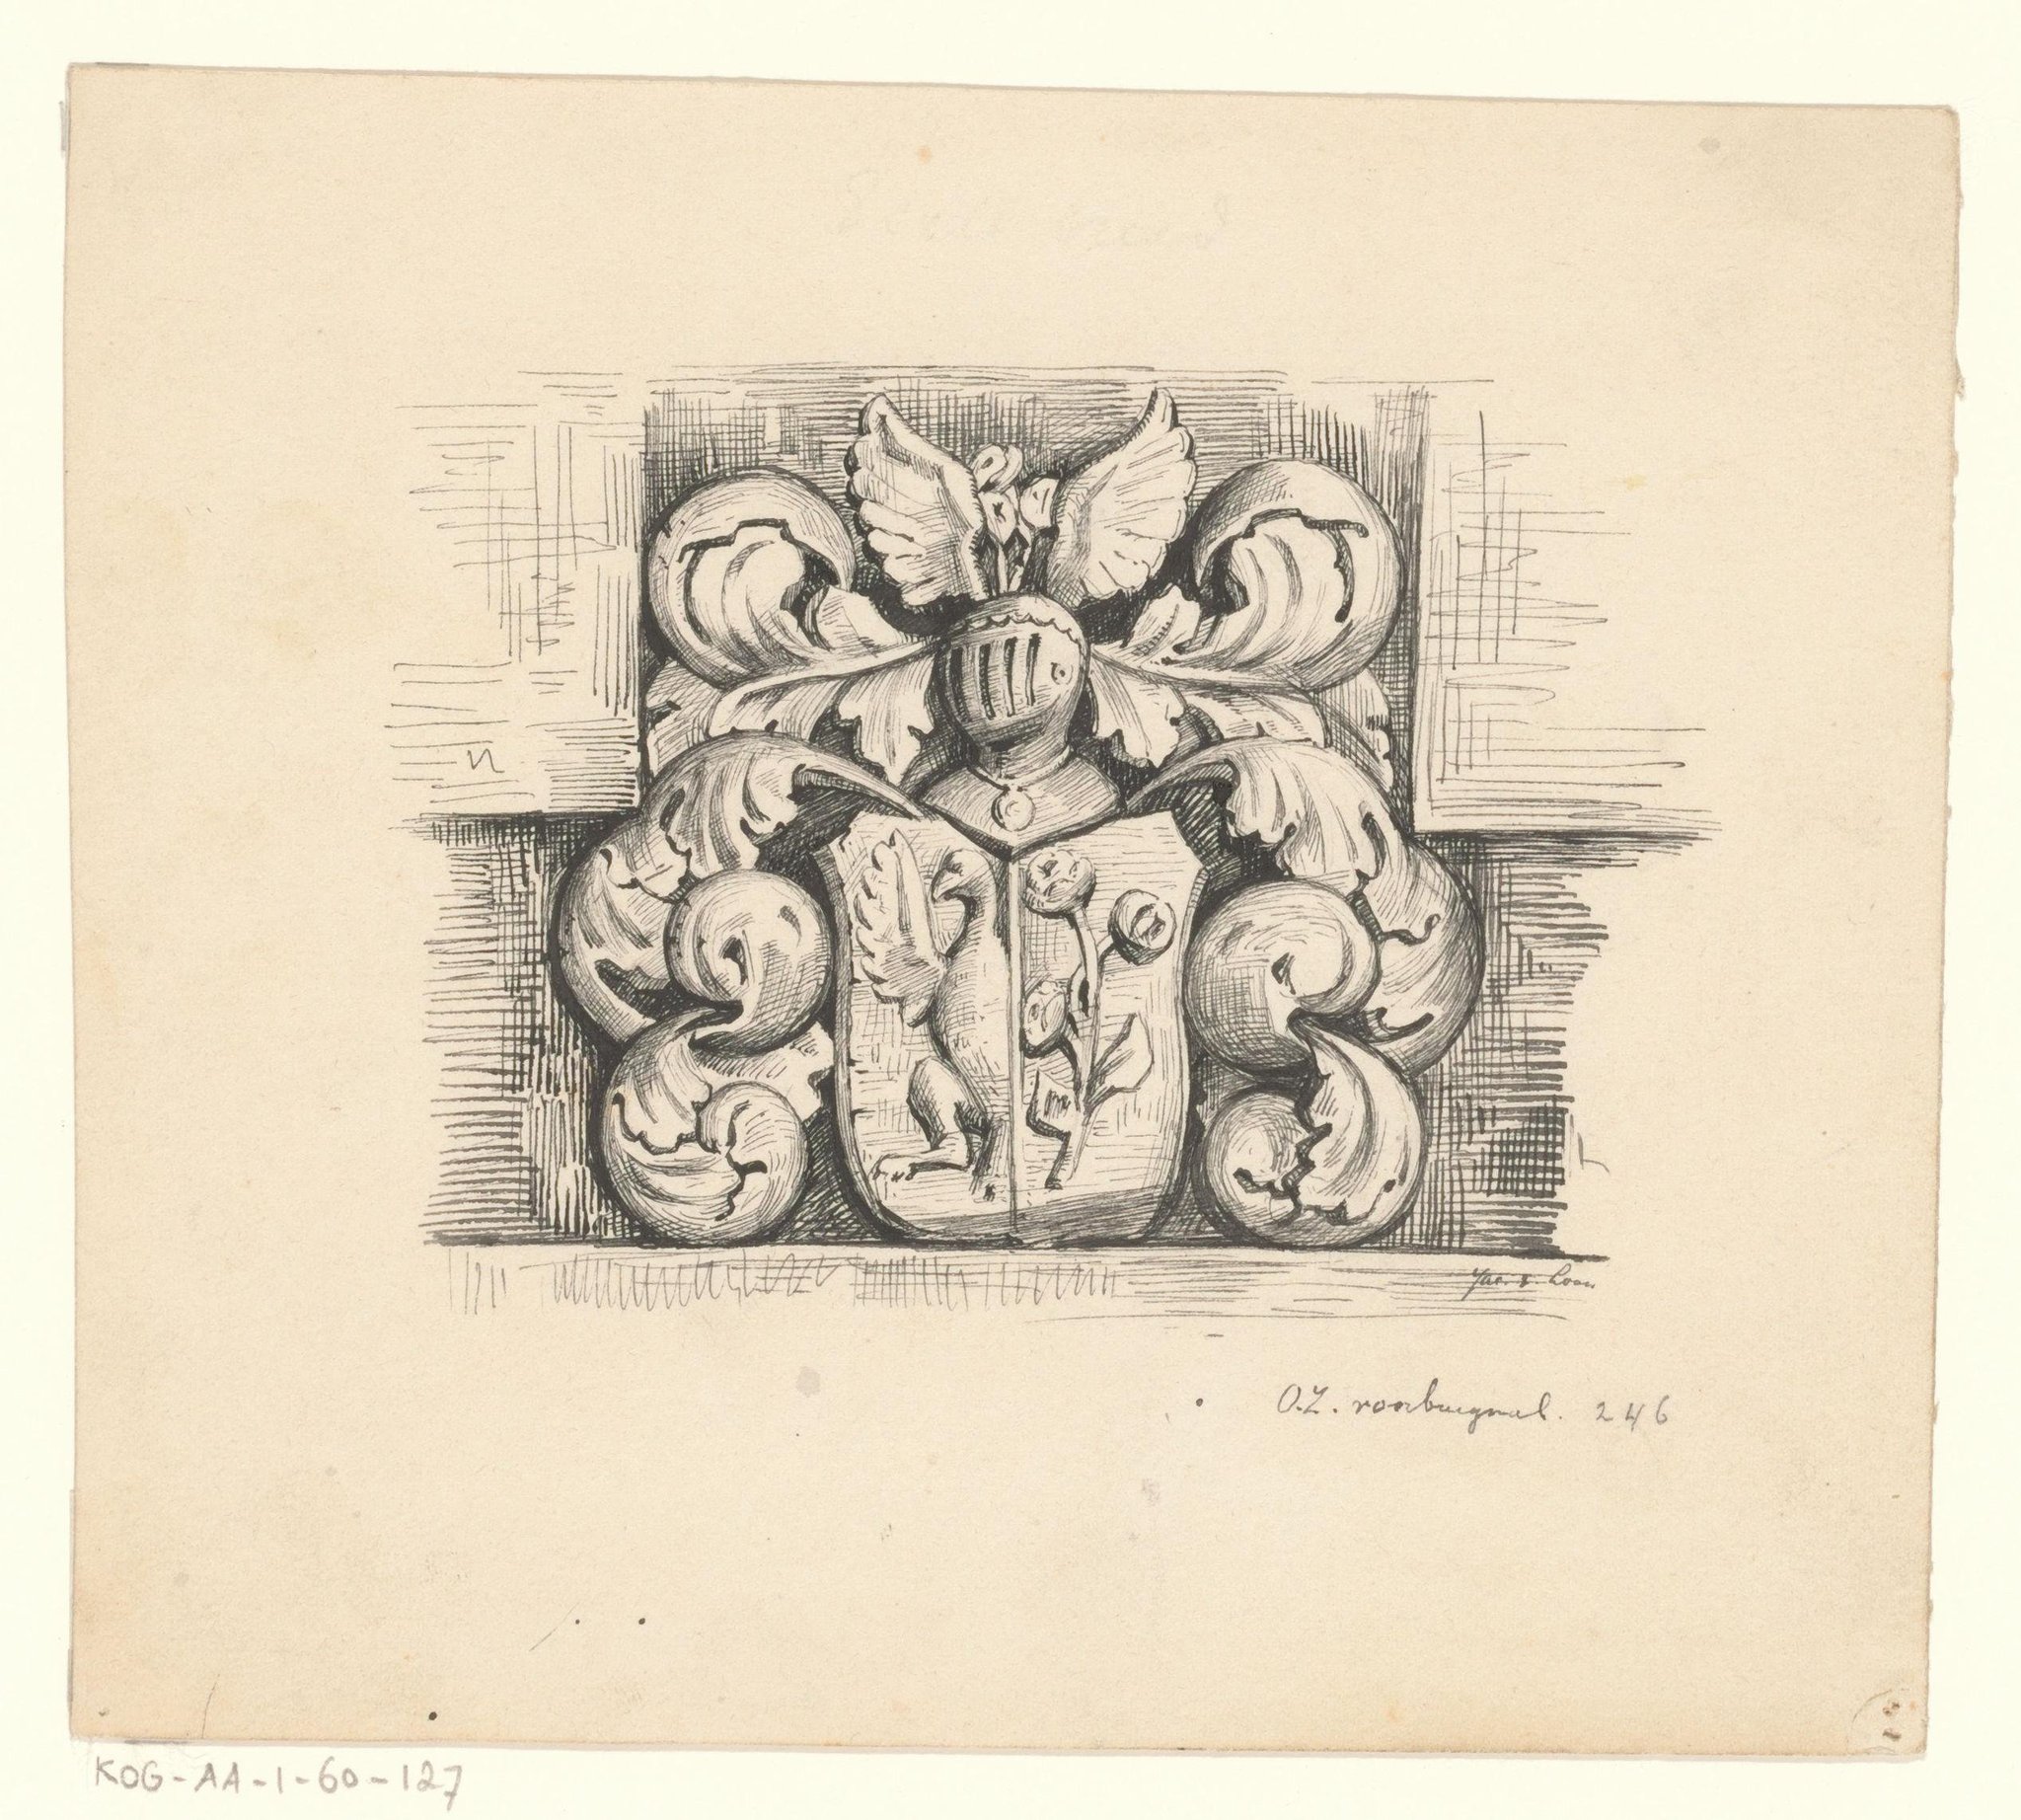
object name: drawing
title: Gevelsteen op de Oudezijds Voorburgwal 246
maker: jac van looij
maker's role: draughtsman, painter, print maker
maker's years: 1855-1930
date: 1865-1930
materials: ink, paper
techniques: pen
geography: amsterdam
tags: stone tablet in façade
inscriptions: signature: ‘Jac. v. Looii’, inscription: ‘O.Z. voorburgwal. 246’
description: Onderwerpsrubriek binnen de Atlas Amsterdam: Beeldhouwkunst - Gevelstenen.